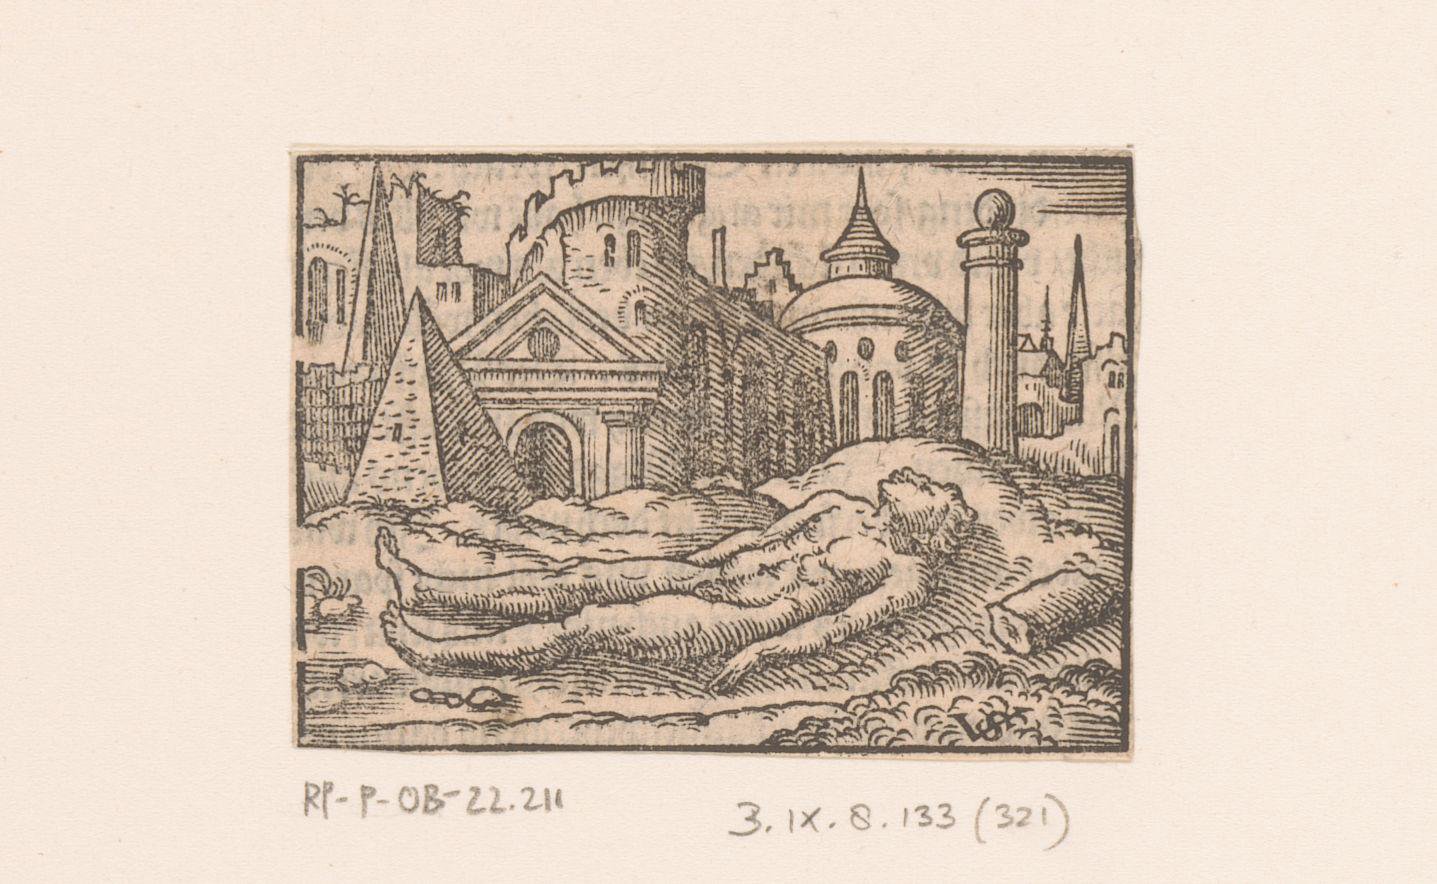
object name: print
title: Liggende naakte man met op de achtergrond een stad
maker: virgilius solis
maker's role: draughtsman, print maker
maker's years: 1514-1562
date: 1566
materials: paper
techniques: woodcut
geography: nuremberg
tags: city-view in general; 'veduta', man (showing himself) undressed, quasi-nude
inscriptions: number: ‘184’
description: Illustratie bij de Fabels van Aesopus, onder meer gebruikt voor de publicatie: Posthius, Johann. Aesopi Phrygis Fabulae. Frankfurt am Main: Sigmund Feyerabend, Georg Rab en erven Weigand Han, 1566.